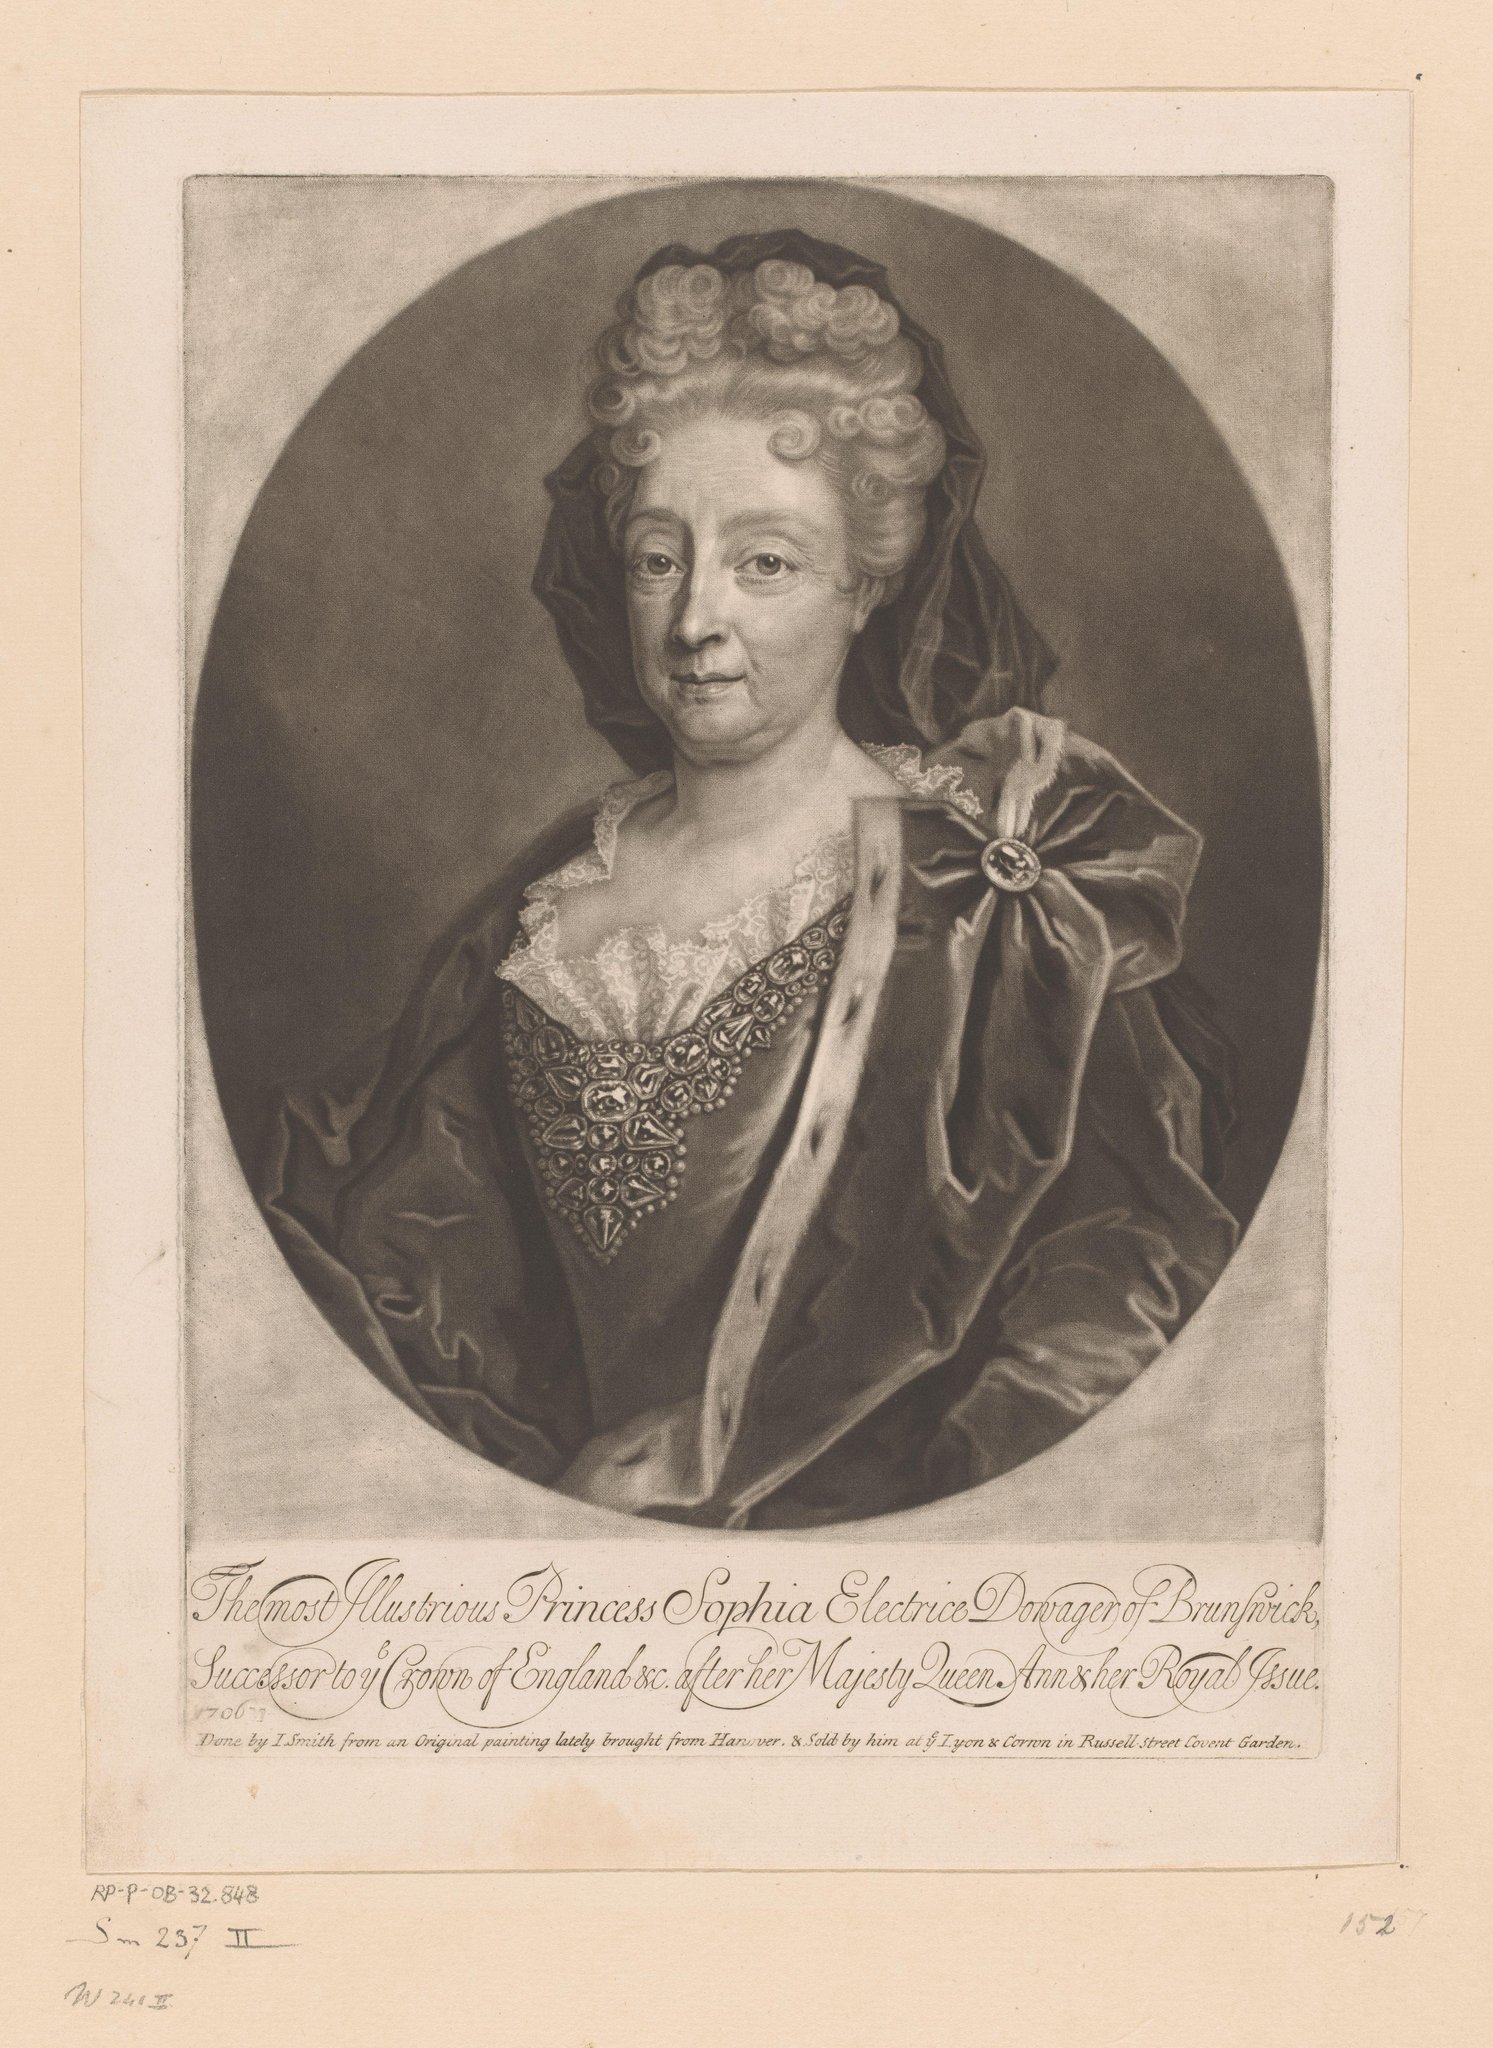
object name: print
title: Portret van Sophia van Hannover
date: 1706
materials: paper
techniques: mezzotint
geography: london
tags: the hague, historical persons, princess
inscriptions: collector's mark: Lugt 240, collector's mark: Lugt 1842